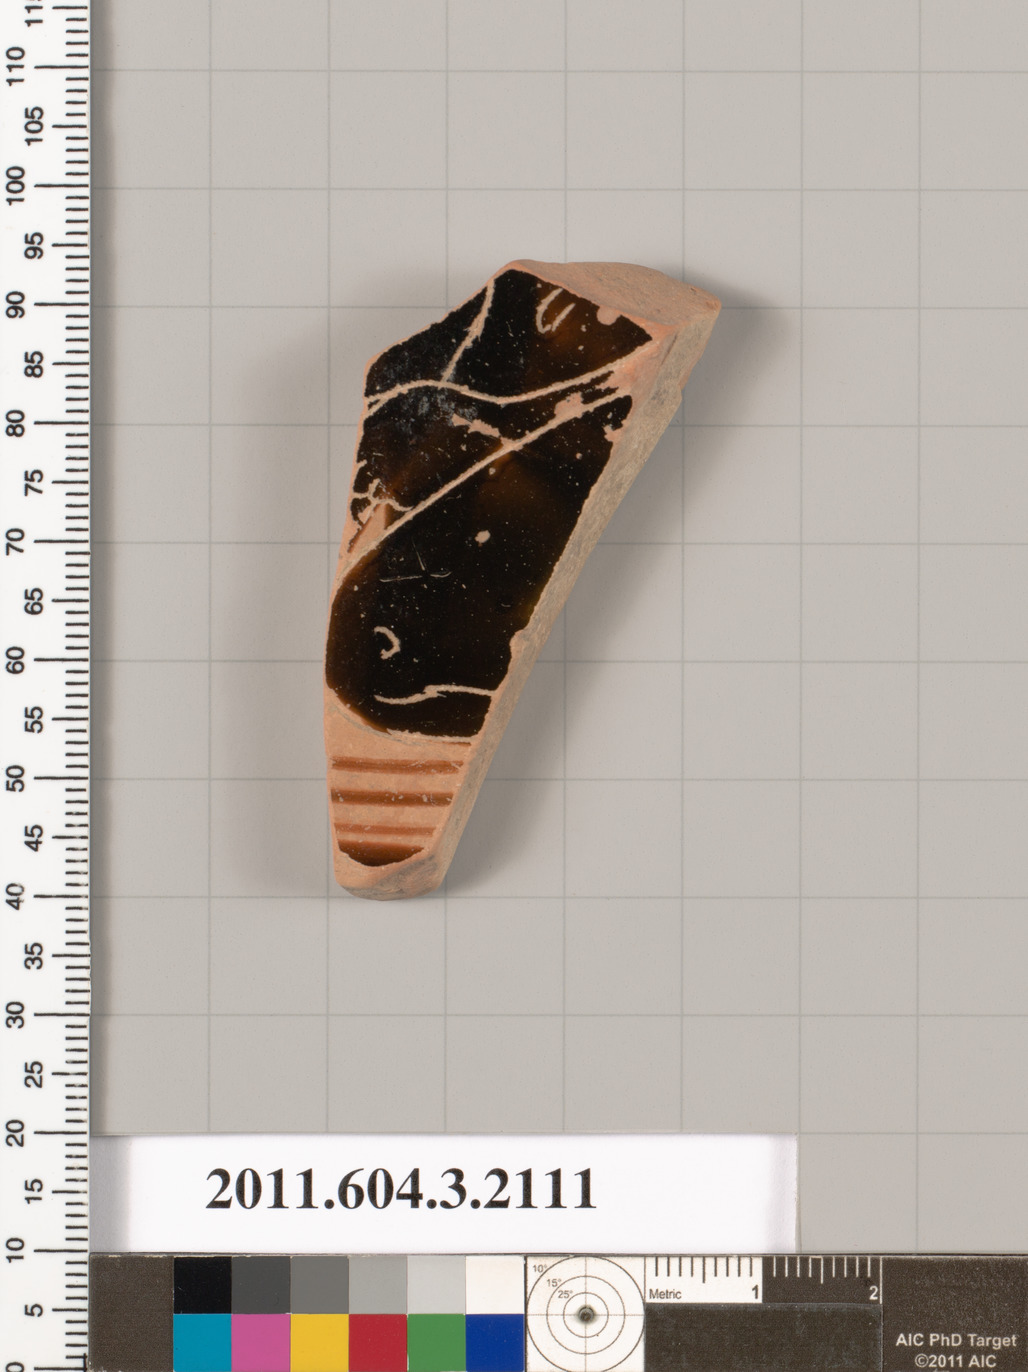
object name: kylix fragment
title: Terracotta fragment of a kylix (drinking cup)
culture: greek, attic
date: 500-480 BCE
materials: terracotta